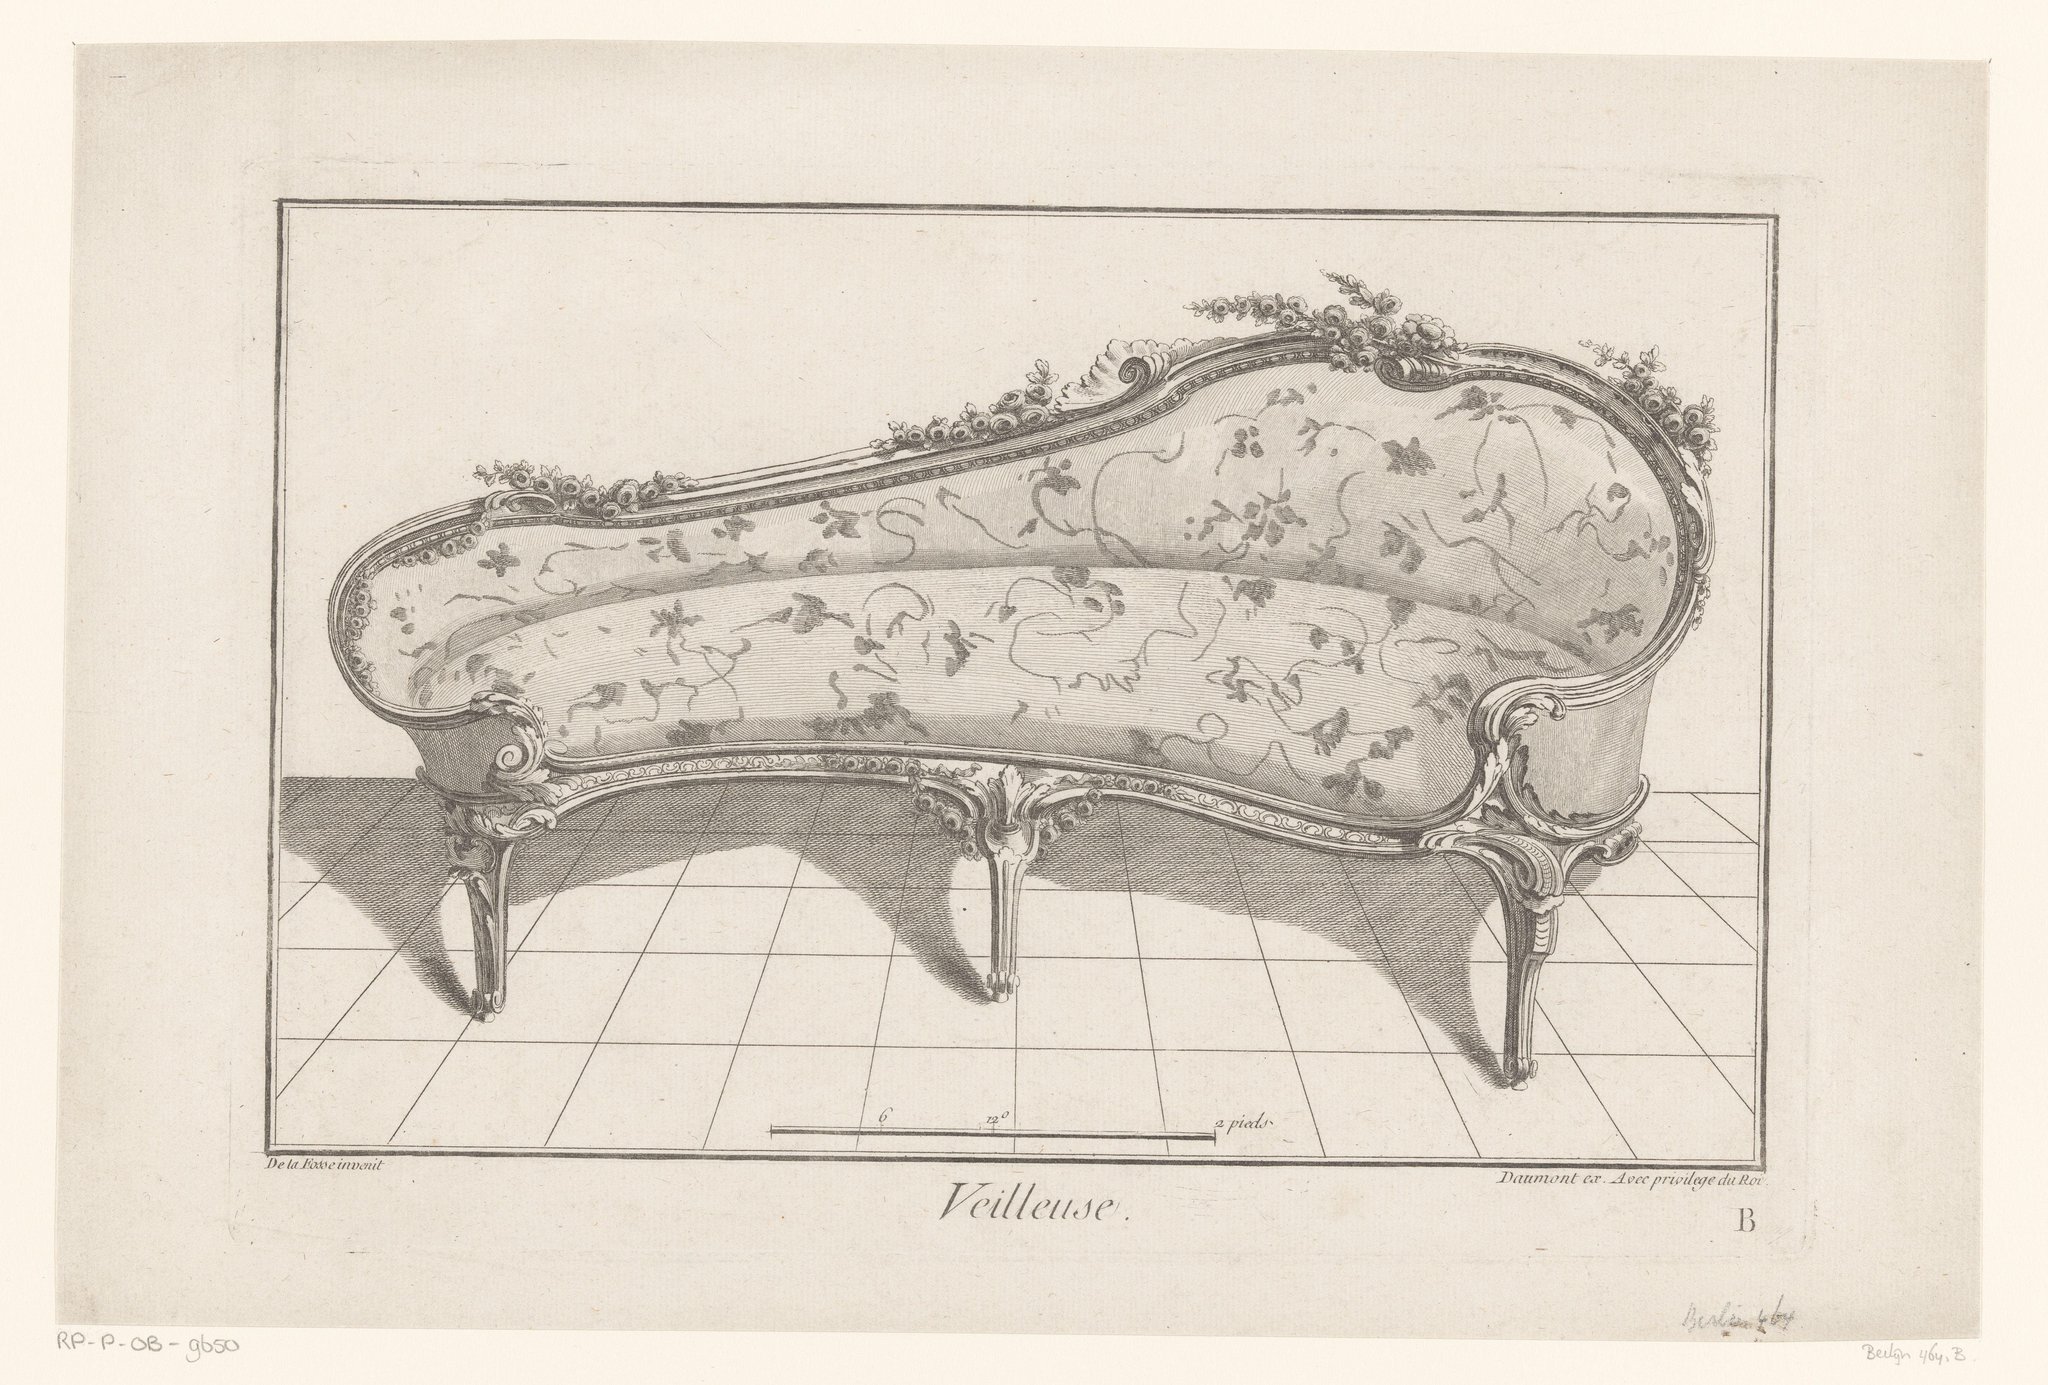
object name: print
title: Veilleuse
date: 1745-1775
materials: paper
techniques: engraving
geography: paris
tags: bench, flowers ~ ornament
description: Een sofa met gedecoreerde bekleding en bloemen.